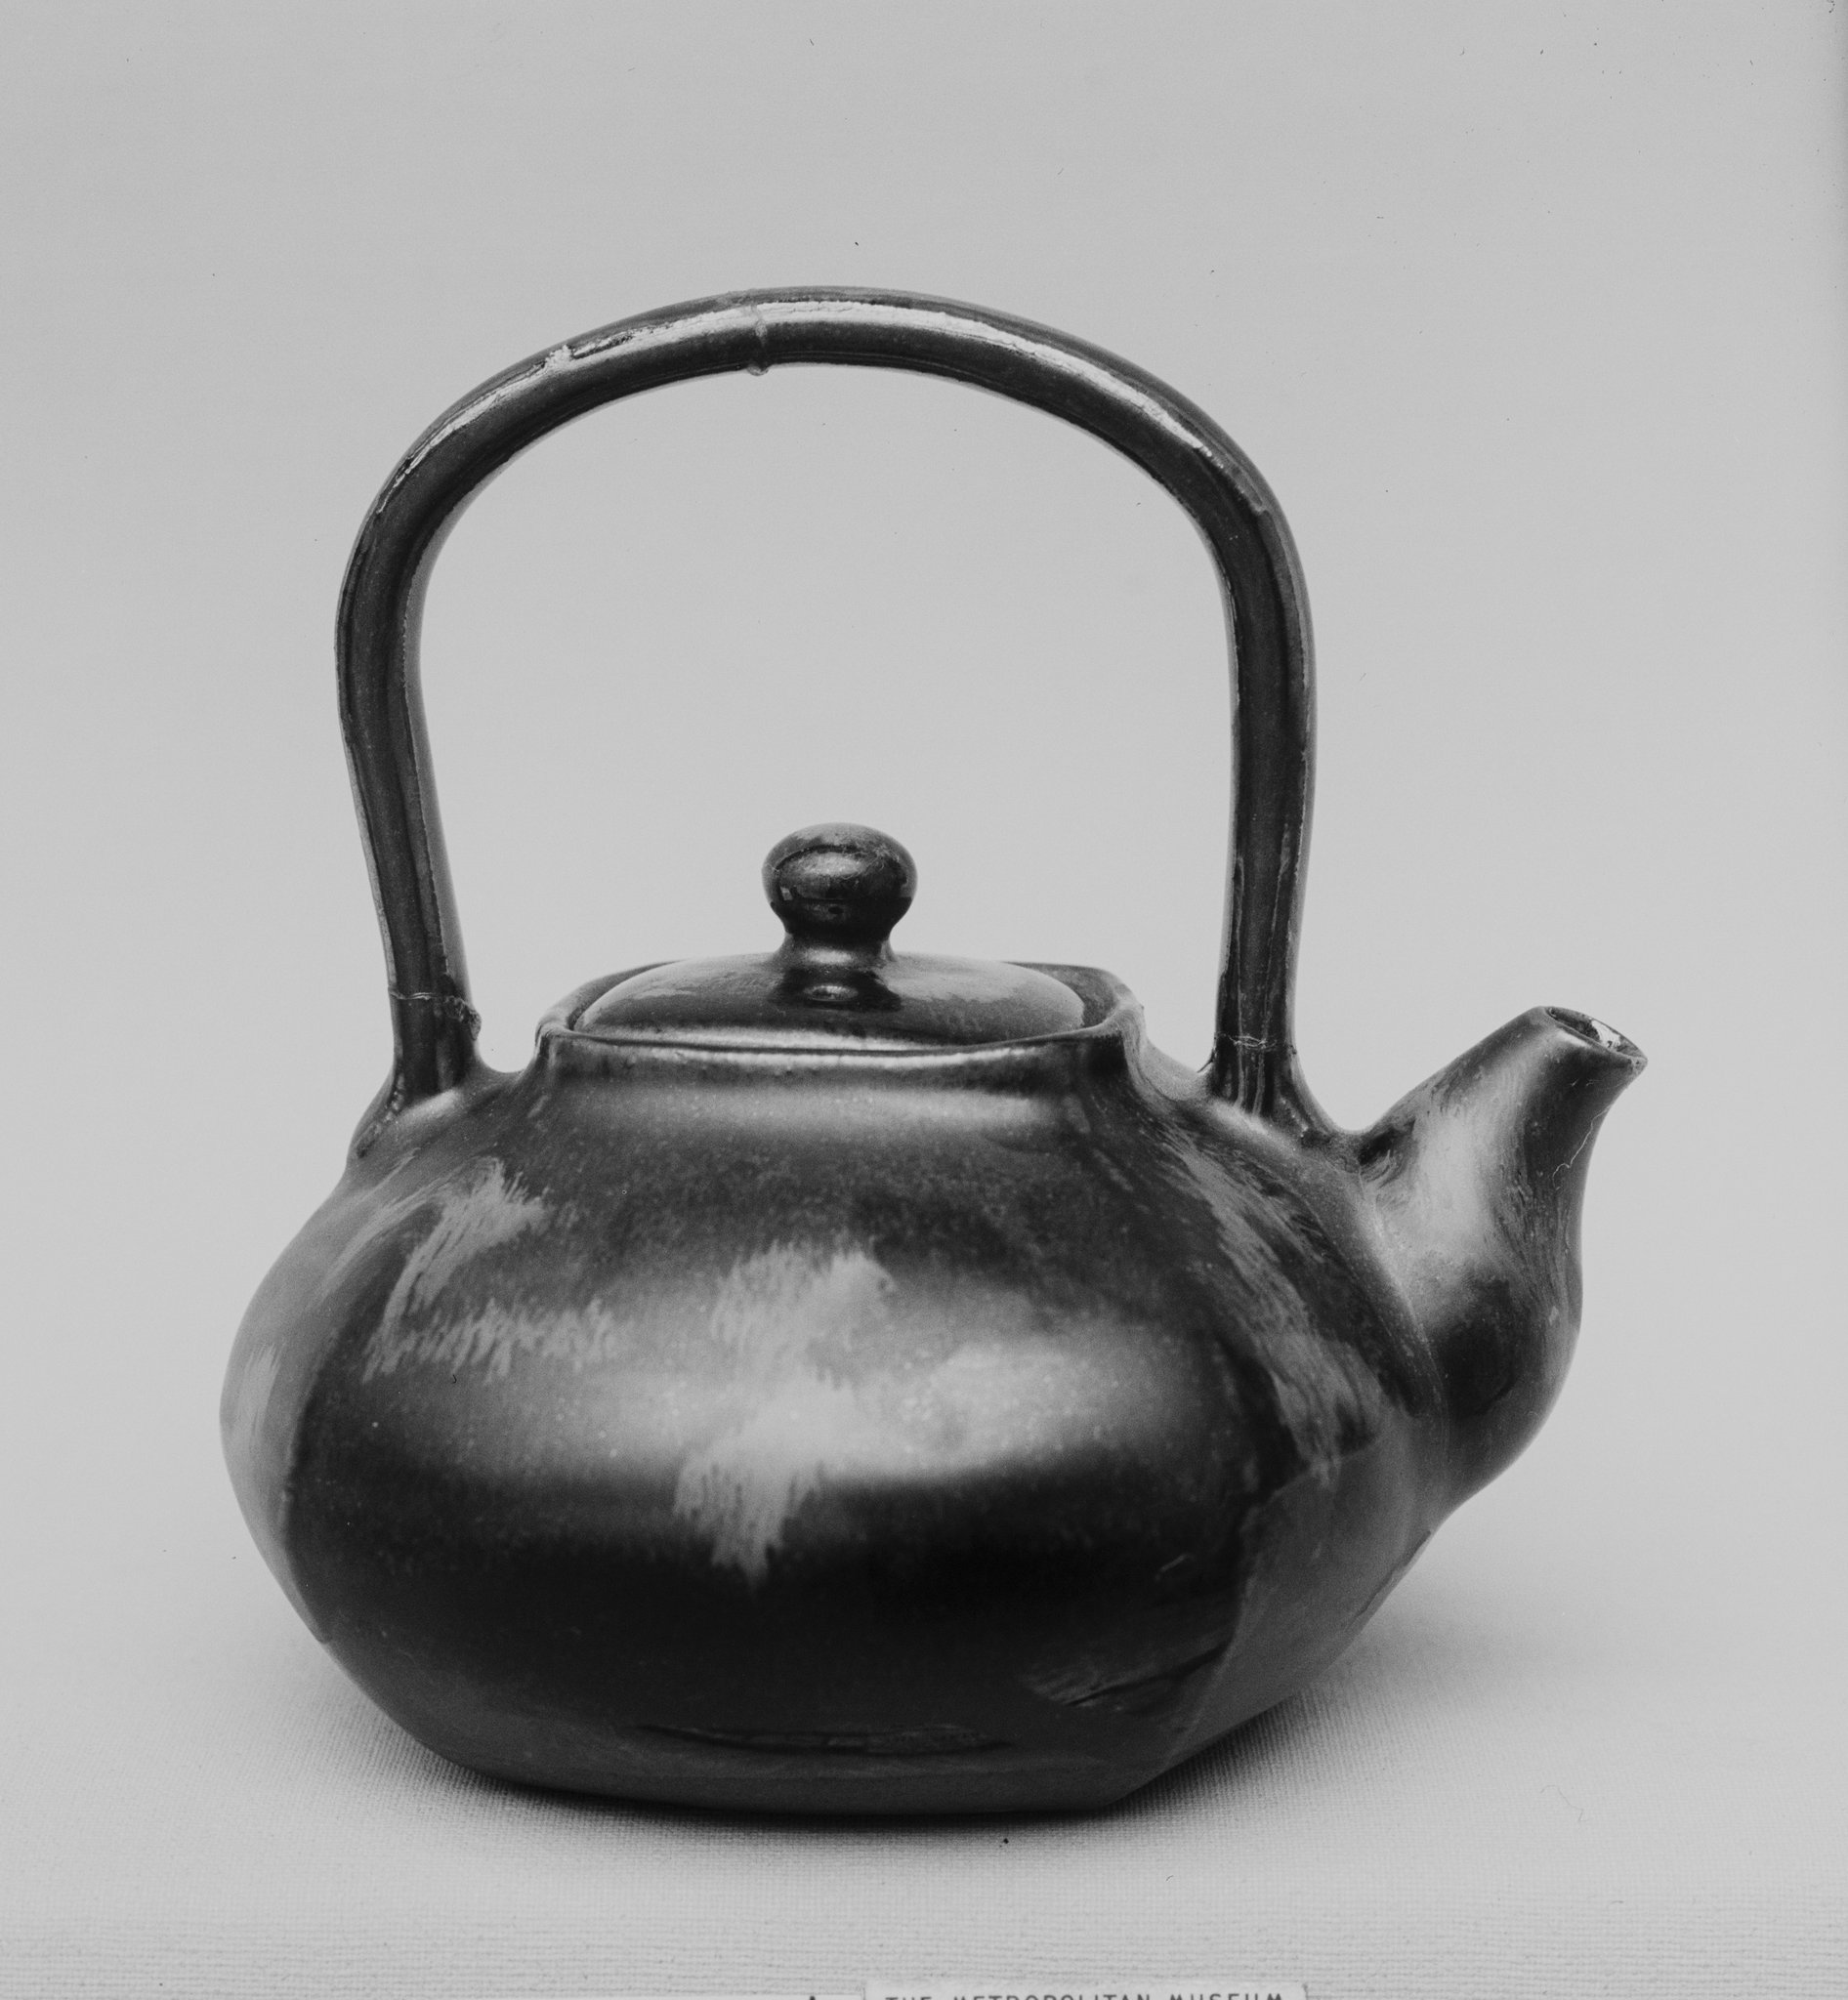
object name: teapot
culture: japanese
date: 1801-1900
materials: clay, glaze